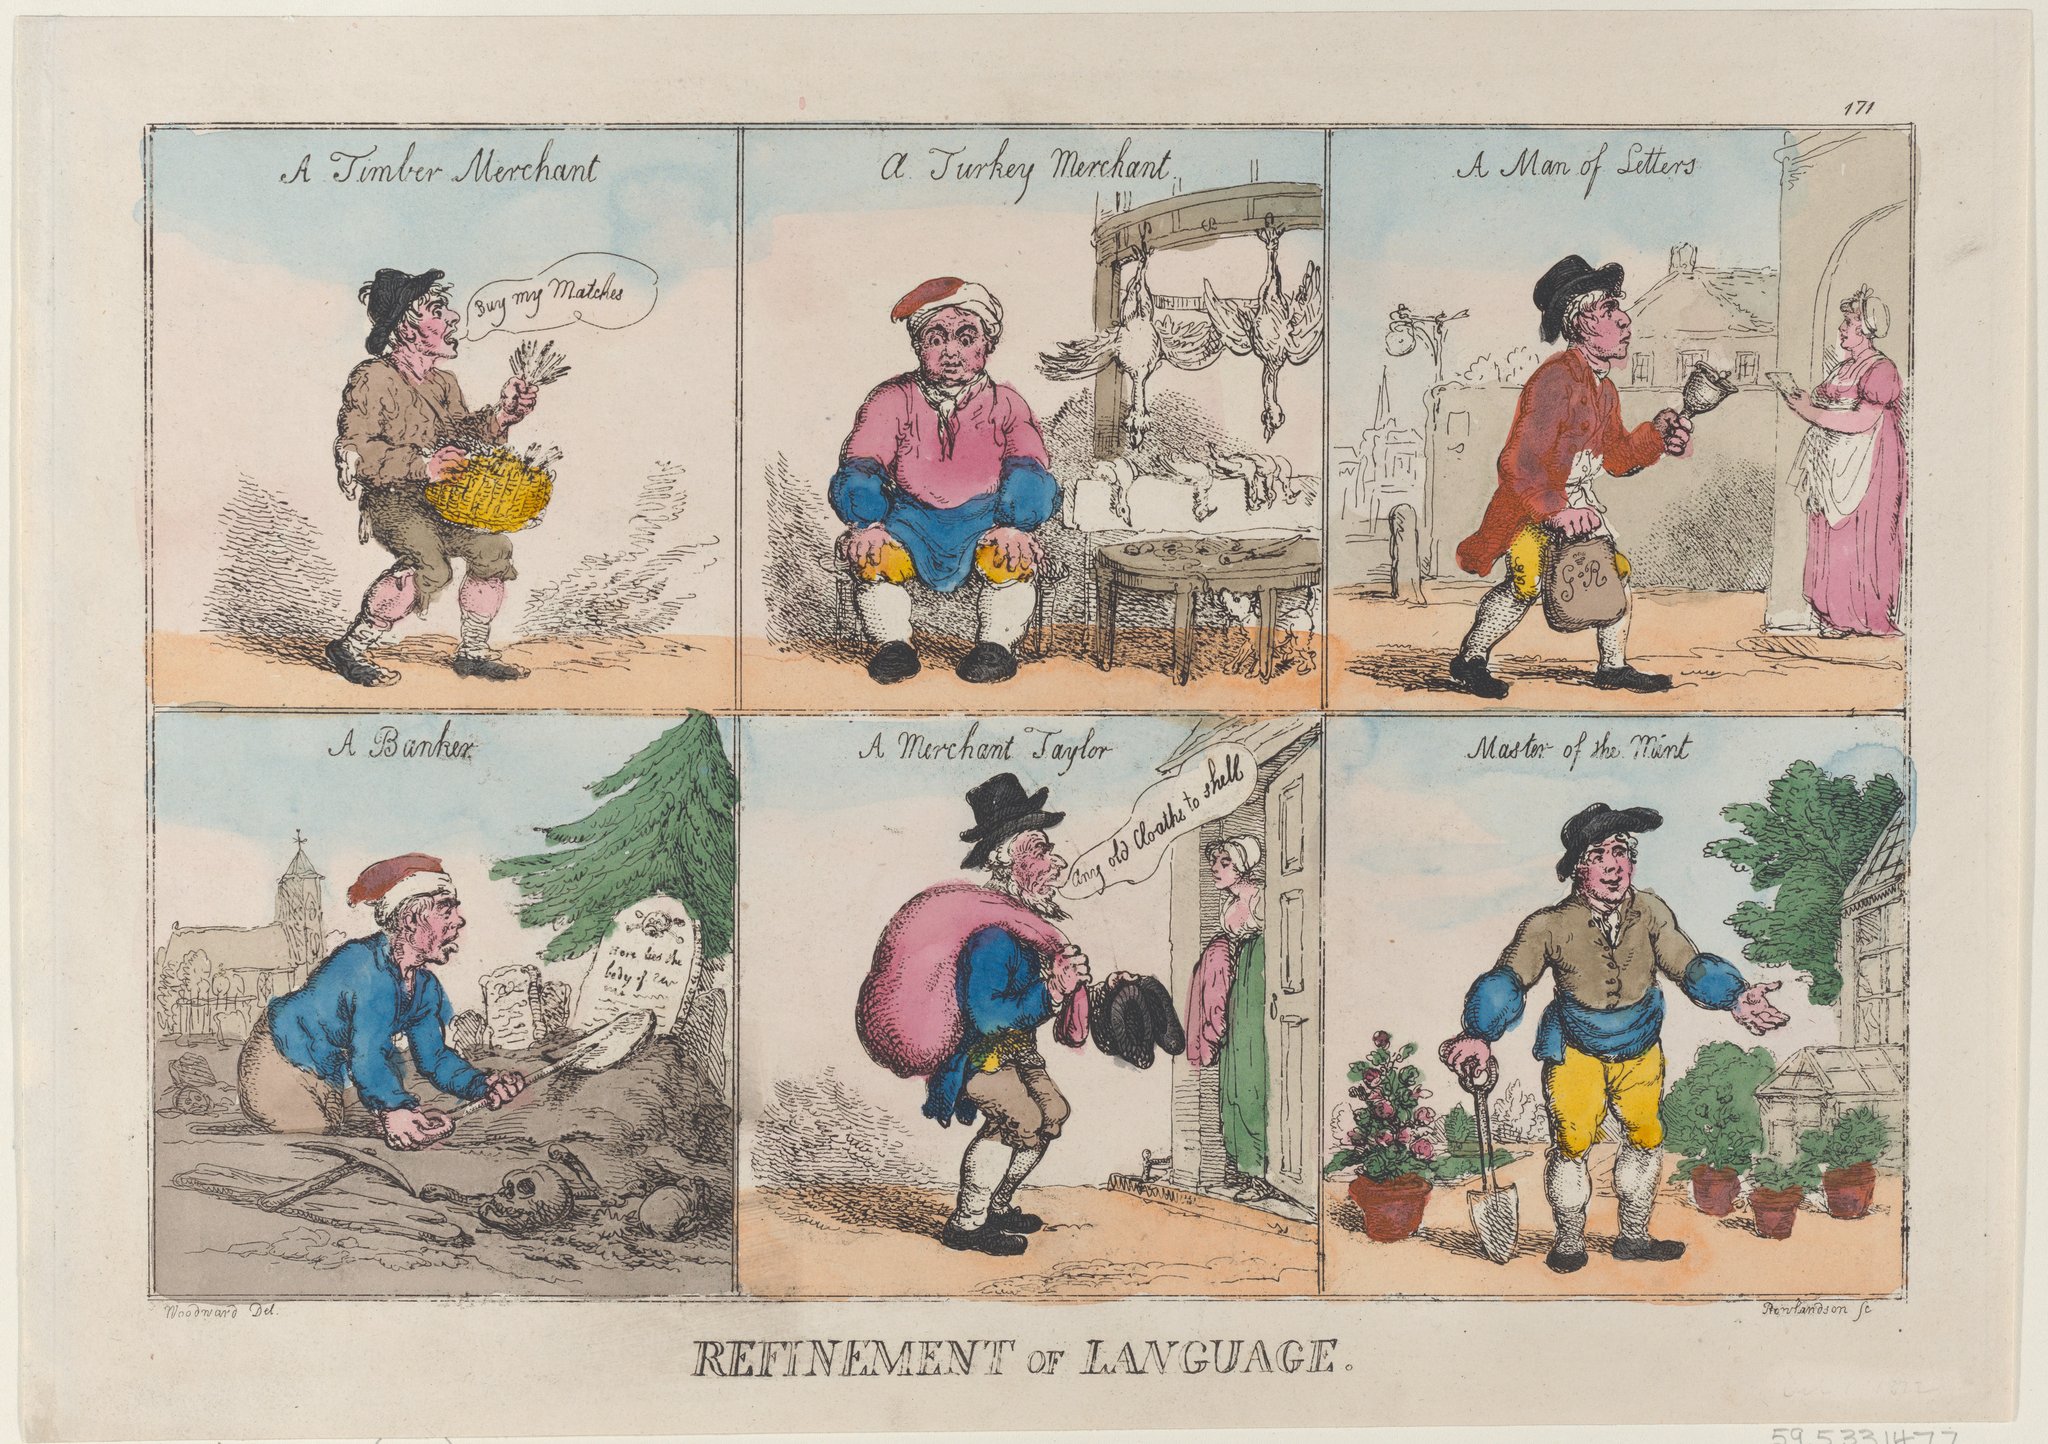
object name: print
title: Refinement of Language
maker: thomas rowlandson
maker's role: artist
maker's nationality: british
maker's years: 1757-1827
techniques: etching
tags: satire,men